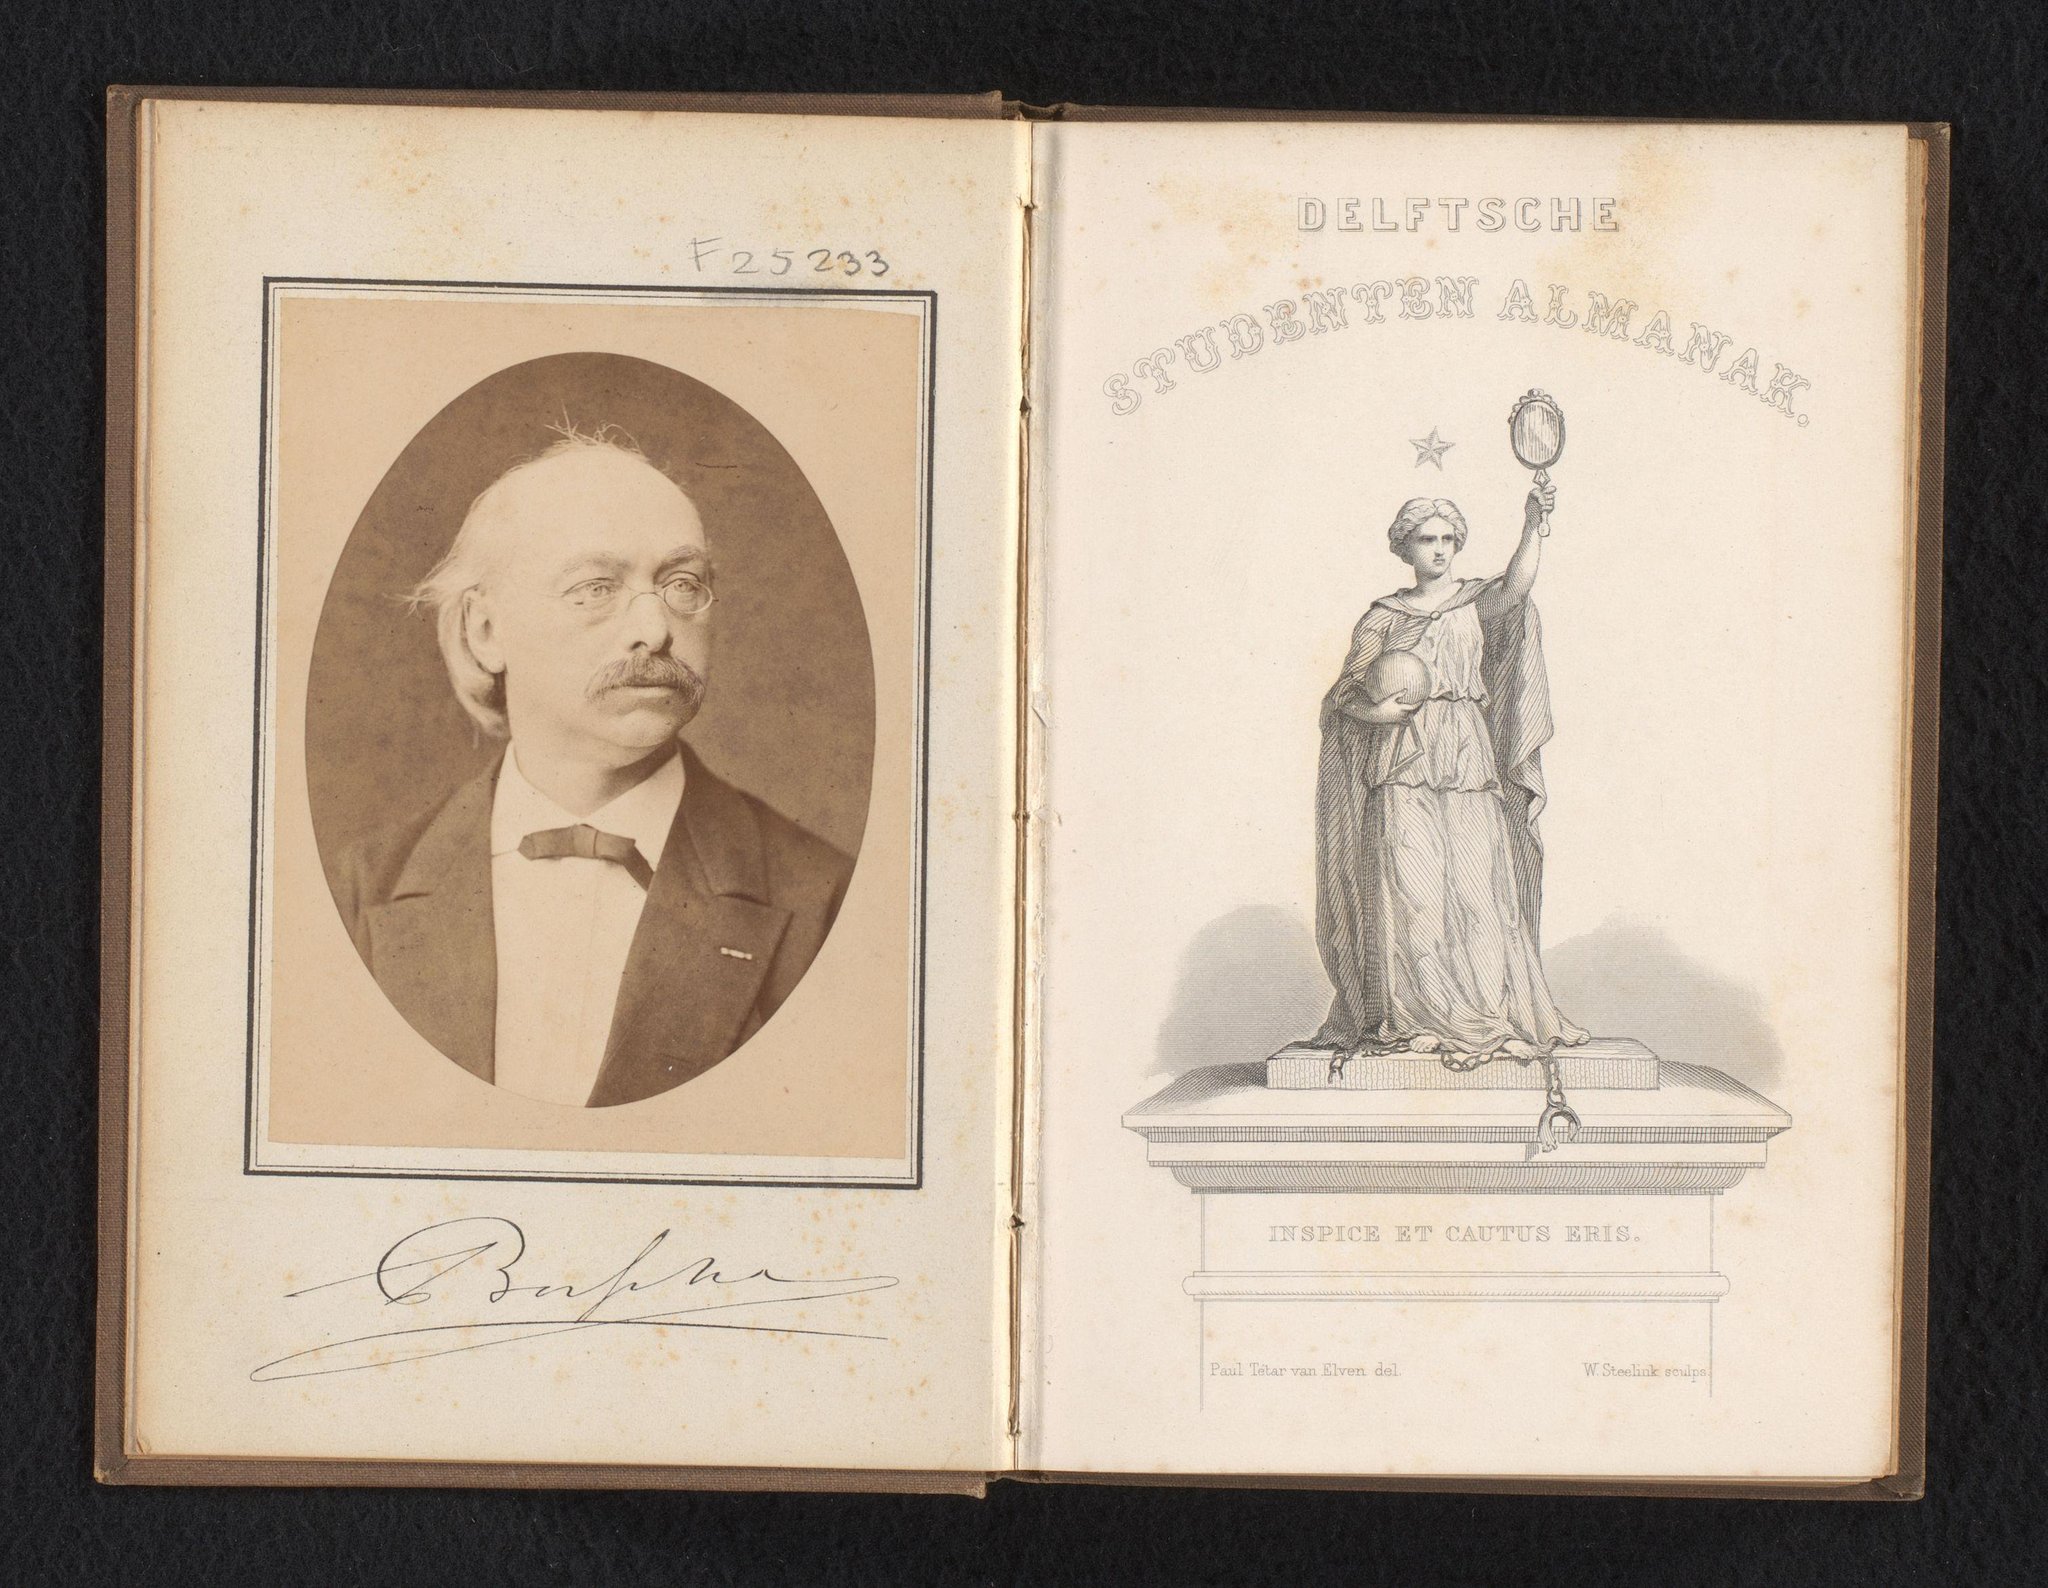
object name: photograph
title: Portret van Johannes Bosscha, hoogleraar toegepaste natuurkunde en directeur van de Polytechnische School Delft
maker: Anonymous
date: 1878-1879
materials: paper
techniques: albumen print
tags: johannes bosscha, historical persons, professor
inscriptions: signature: ‘Bosscha’